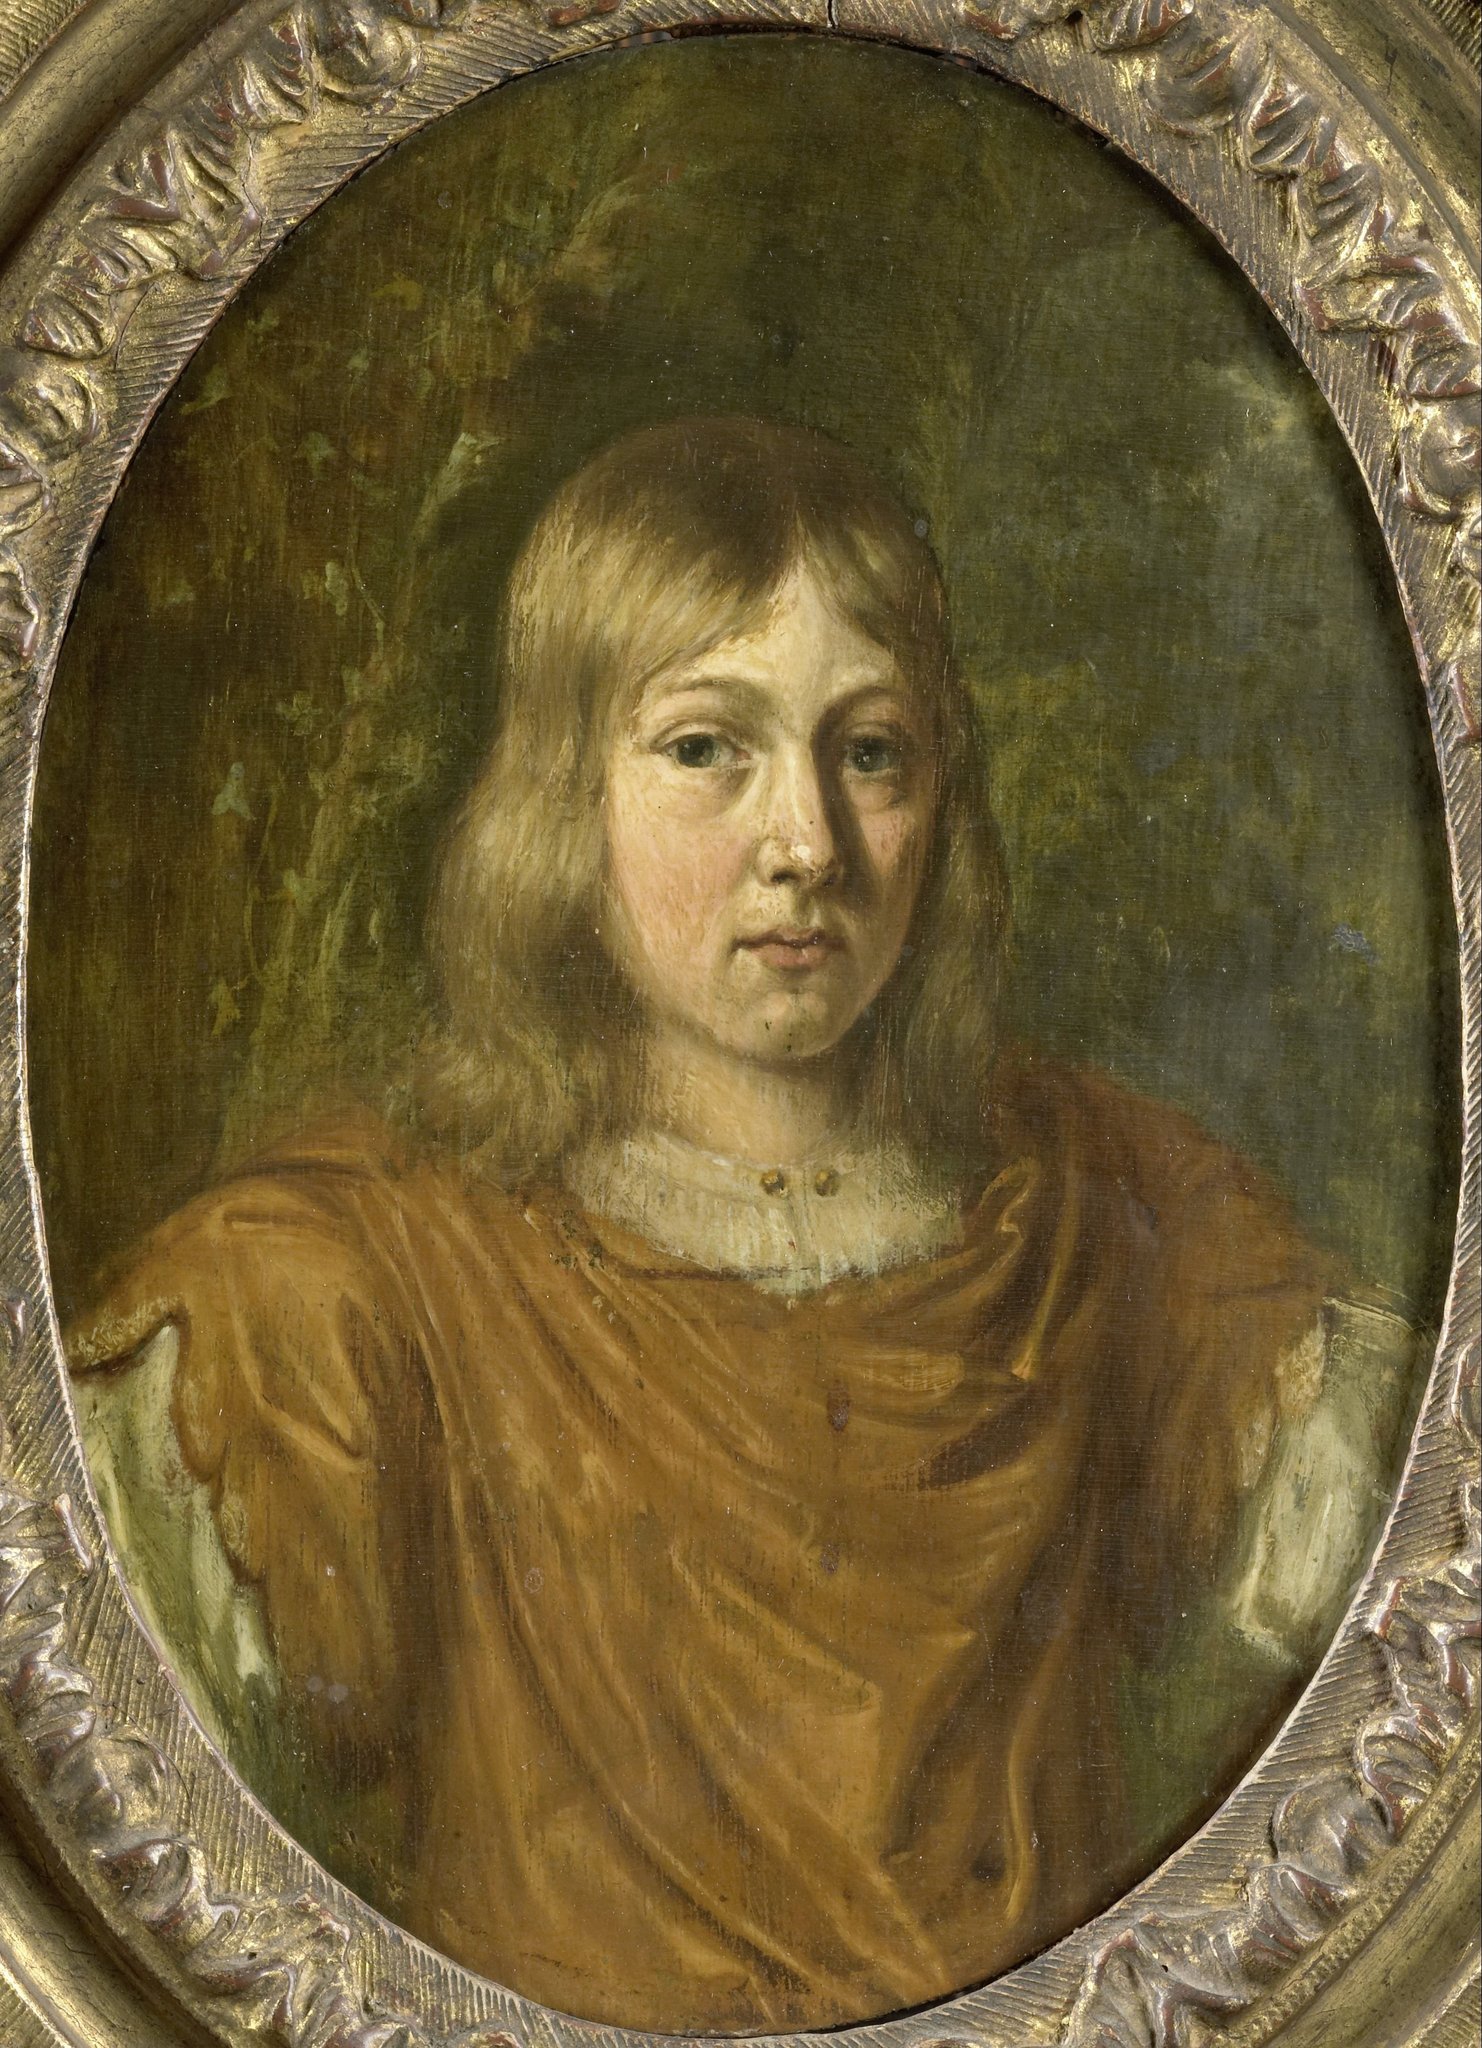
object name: painting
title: Portrait of a young Man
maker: jan van mieris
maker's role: draughtsman, painter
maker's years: 1660-1690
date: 1680-1690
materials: oil, panel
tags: anonymous historical person portrayed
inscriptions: signature: ‘J. Mieris’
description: Portret van een jonge man, buste in een ovaal, tegen een achtergrond van gebladerte.